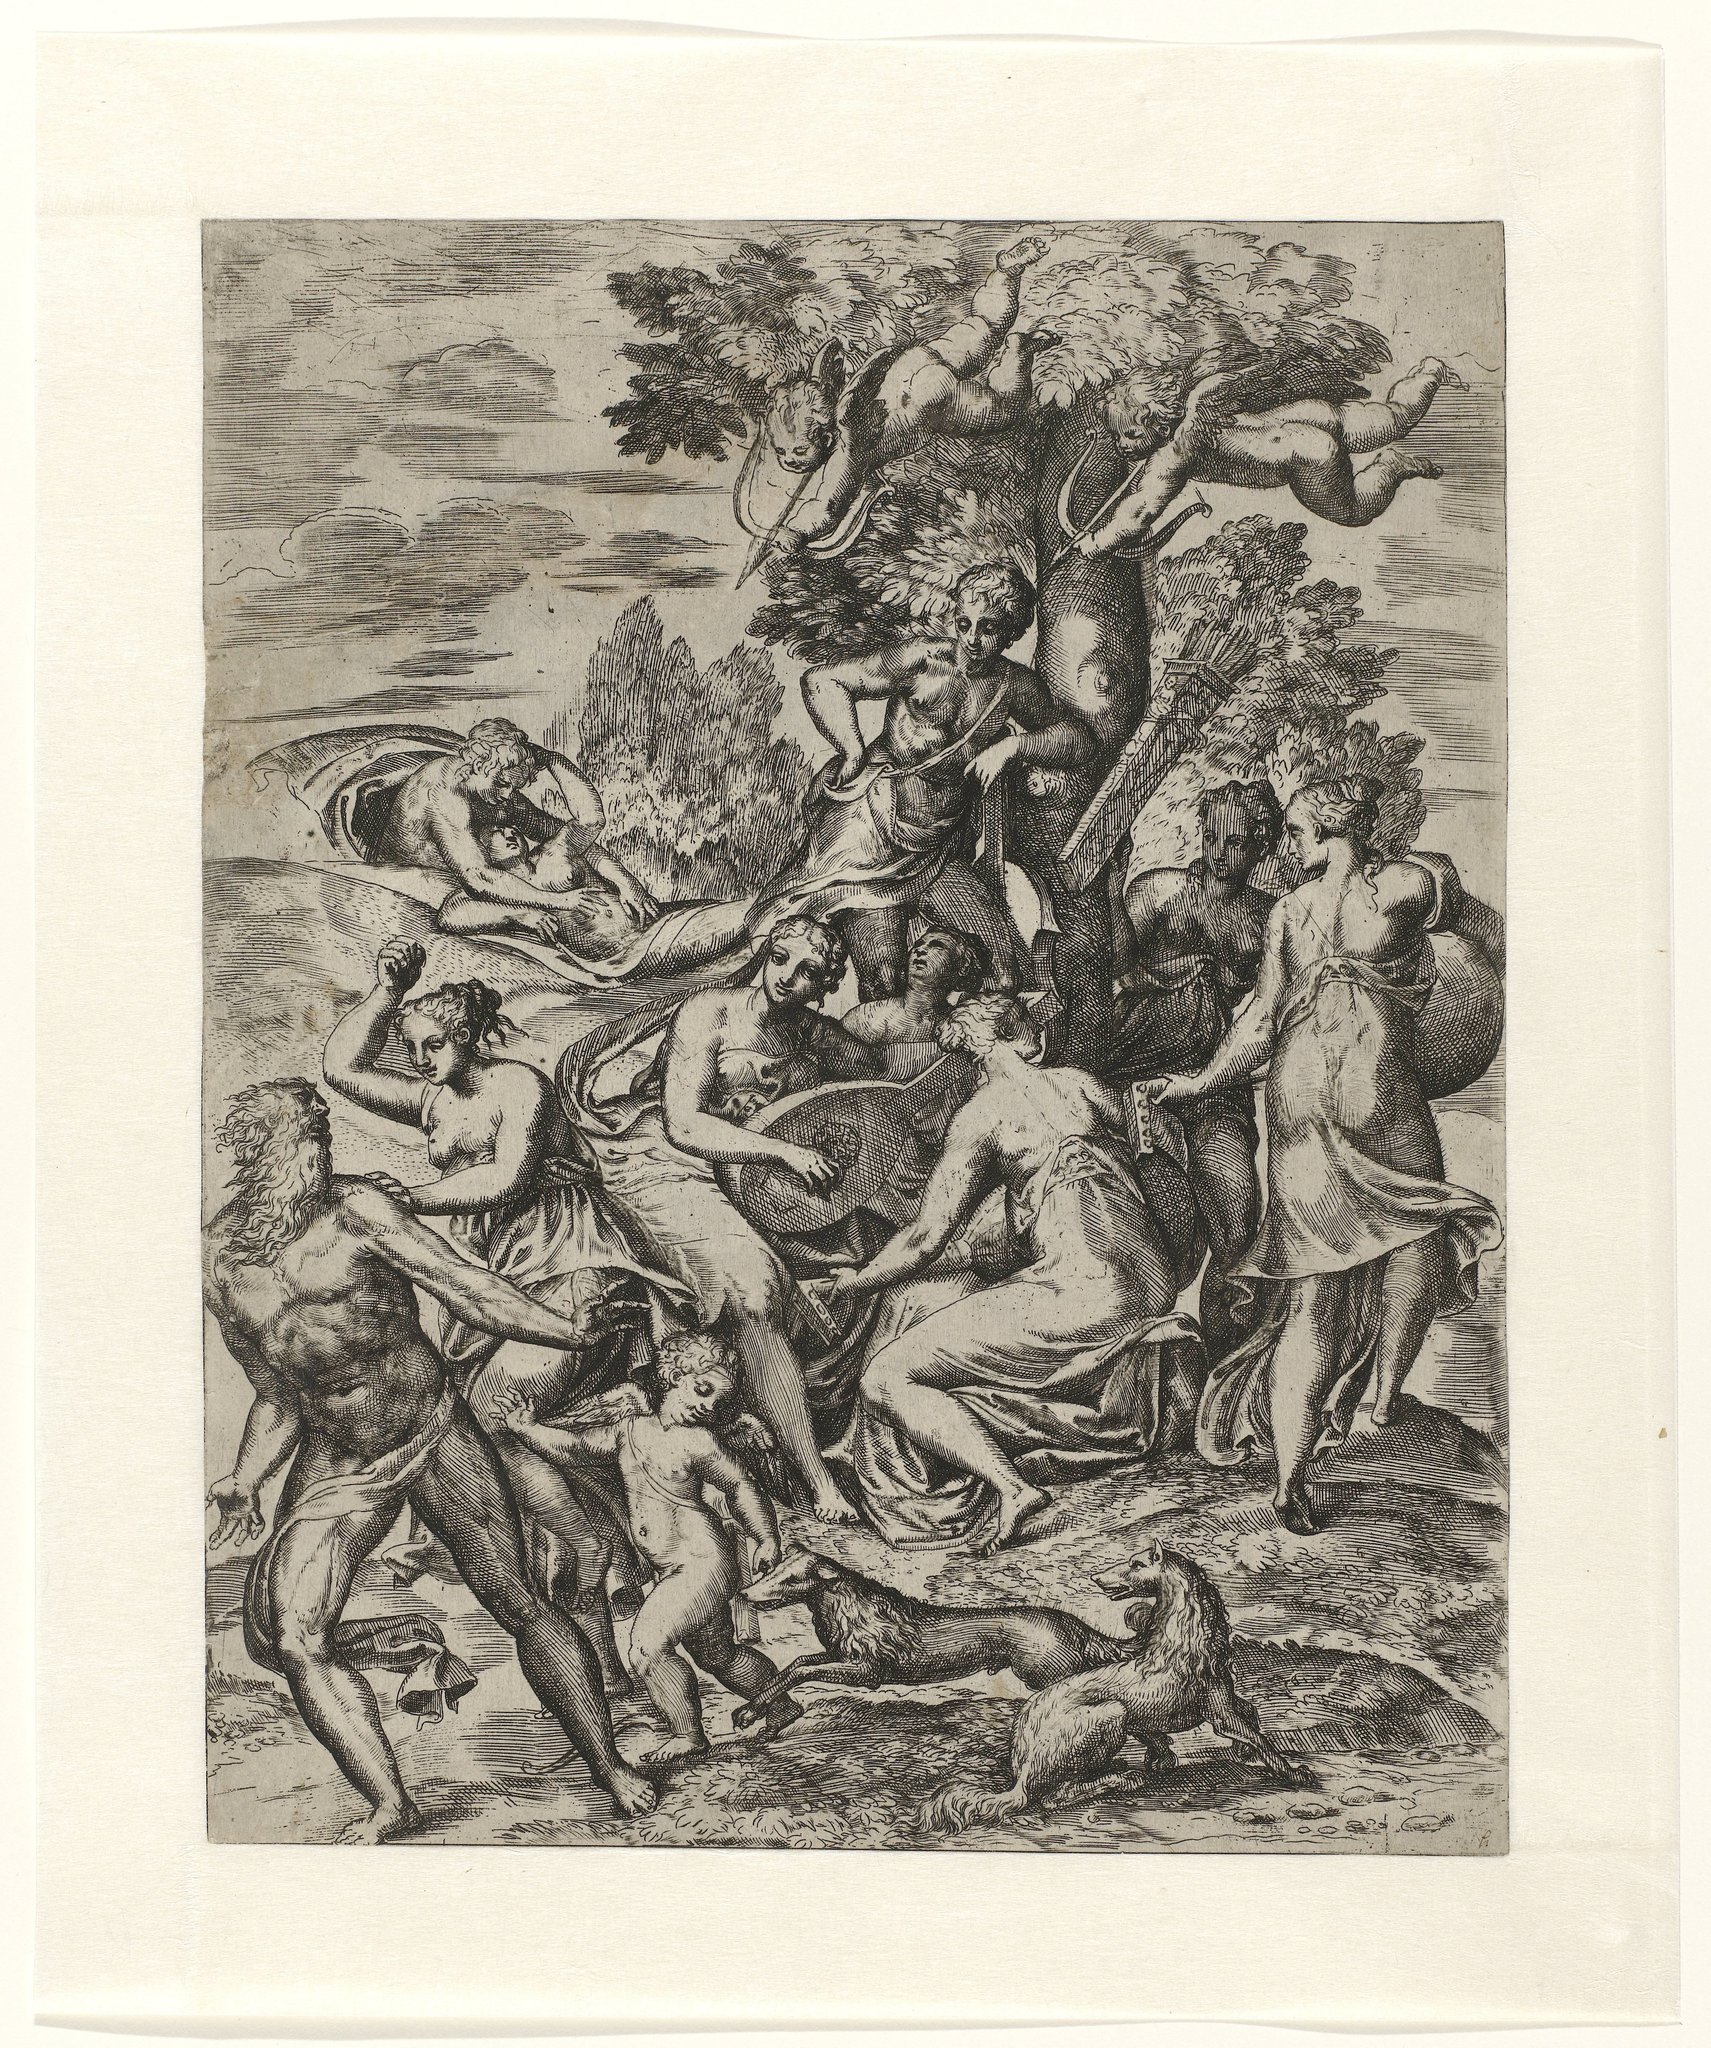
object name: print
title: Tuin der liefde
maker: marco dellangolo del moro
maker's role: print maker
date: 1550-1586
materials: paper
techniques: engraving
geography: italy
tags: nymphs (in general); 'ninfe in commune' (ripa), garden of love, court of love, 'fête galante', lute, and special forms of lute, e.g.: theorbo - cc - out of doors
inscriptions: collector's mark: Lugt 2760, collector's mark: Lugt 2228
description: Een groep halfnaakte vrouwen zit onder een boom waarvan er drie spelen op een luit. In de lucht twee putti die pijl en boog richten op een oude man met baard die door een vrouw samen met een putto wordt verjaagd